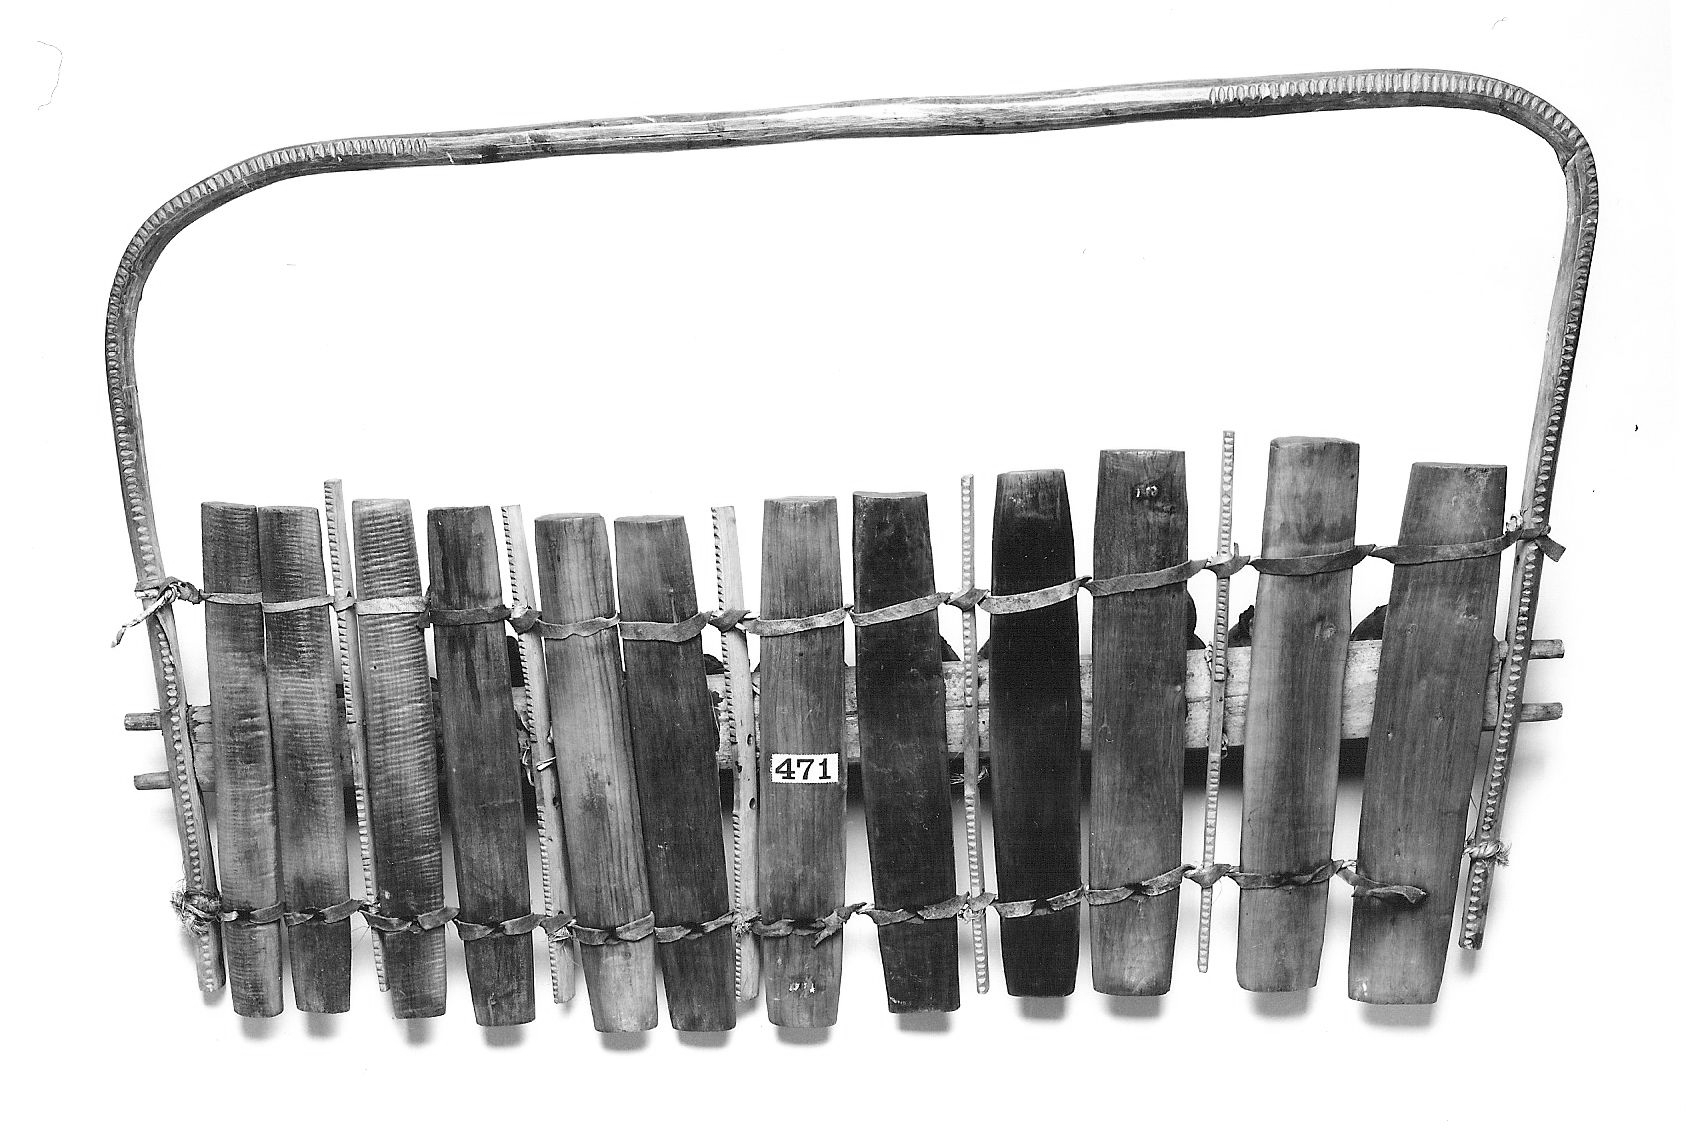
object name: timbila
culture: chopi people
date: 1801-1900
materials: leather, skin, wood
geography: mozambique